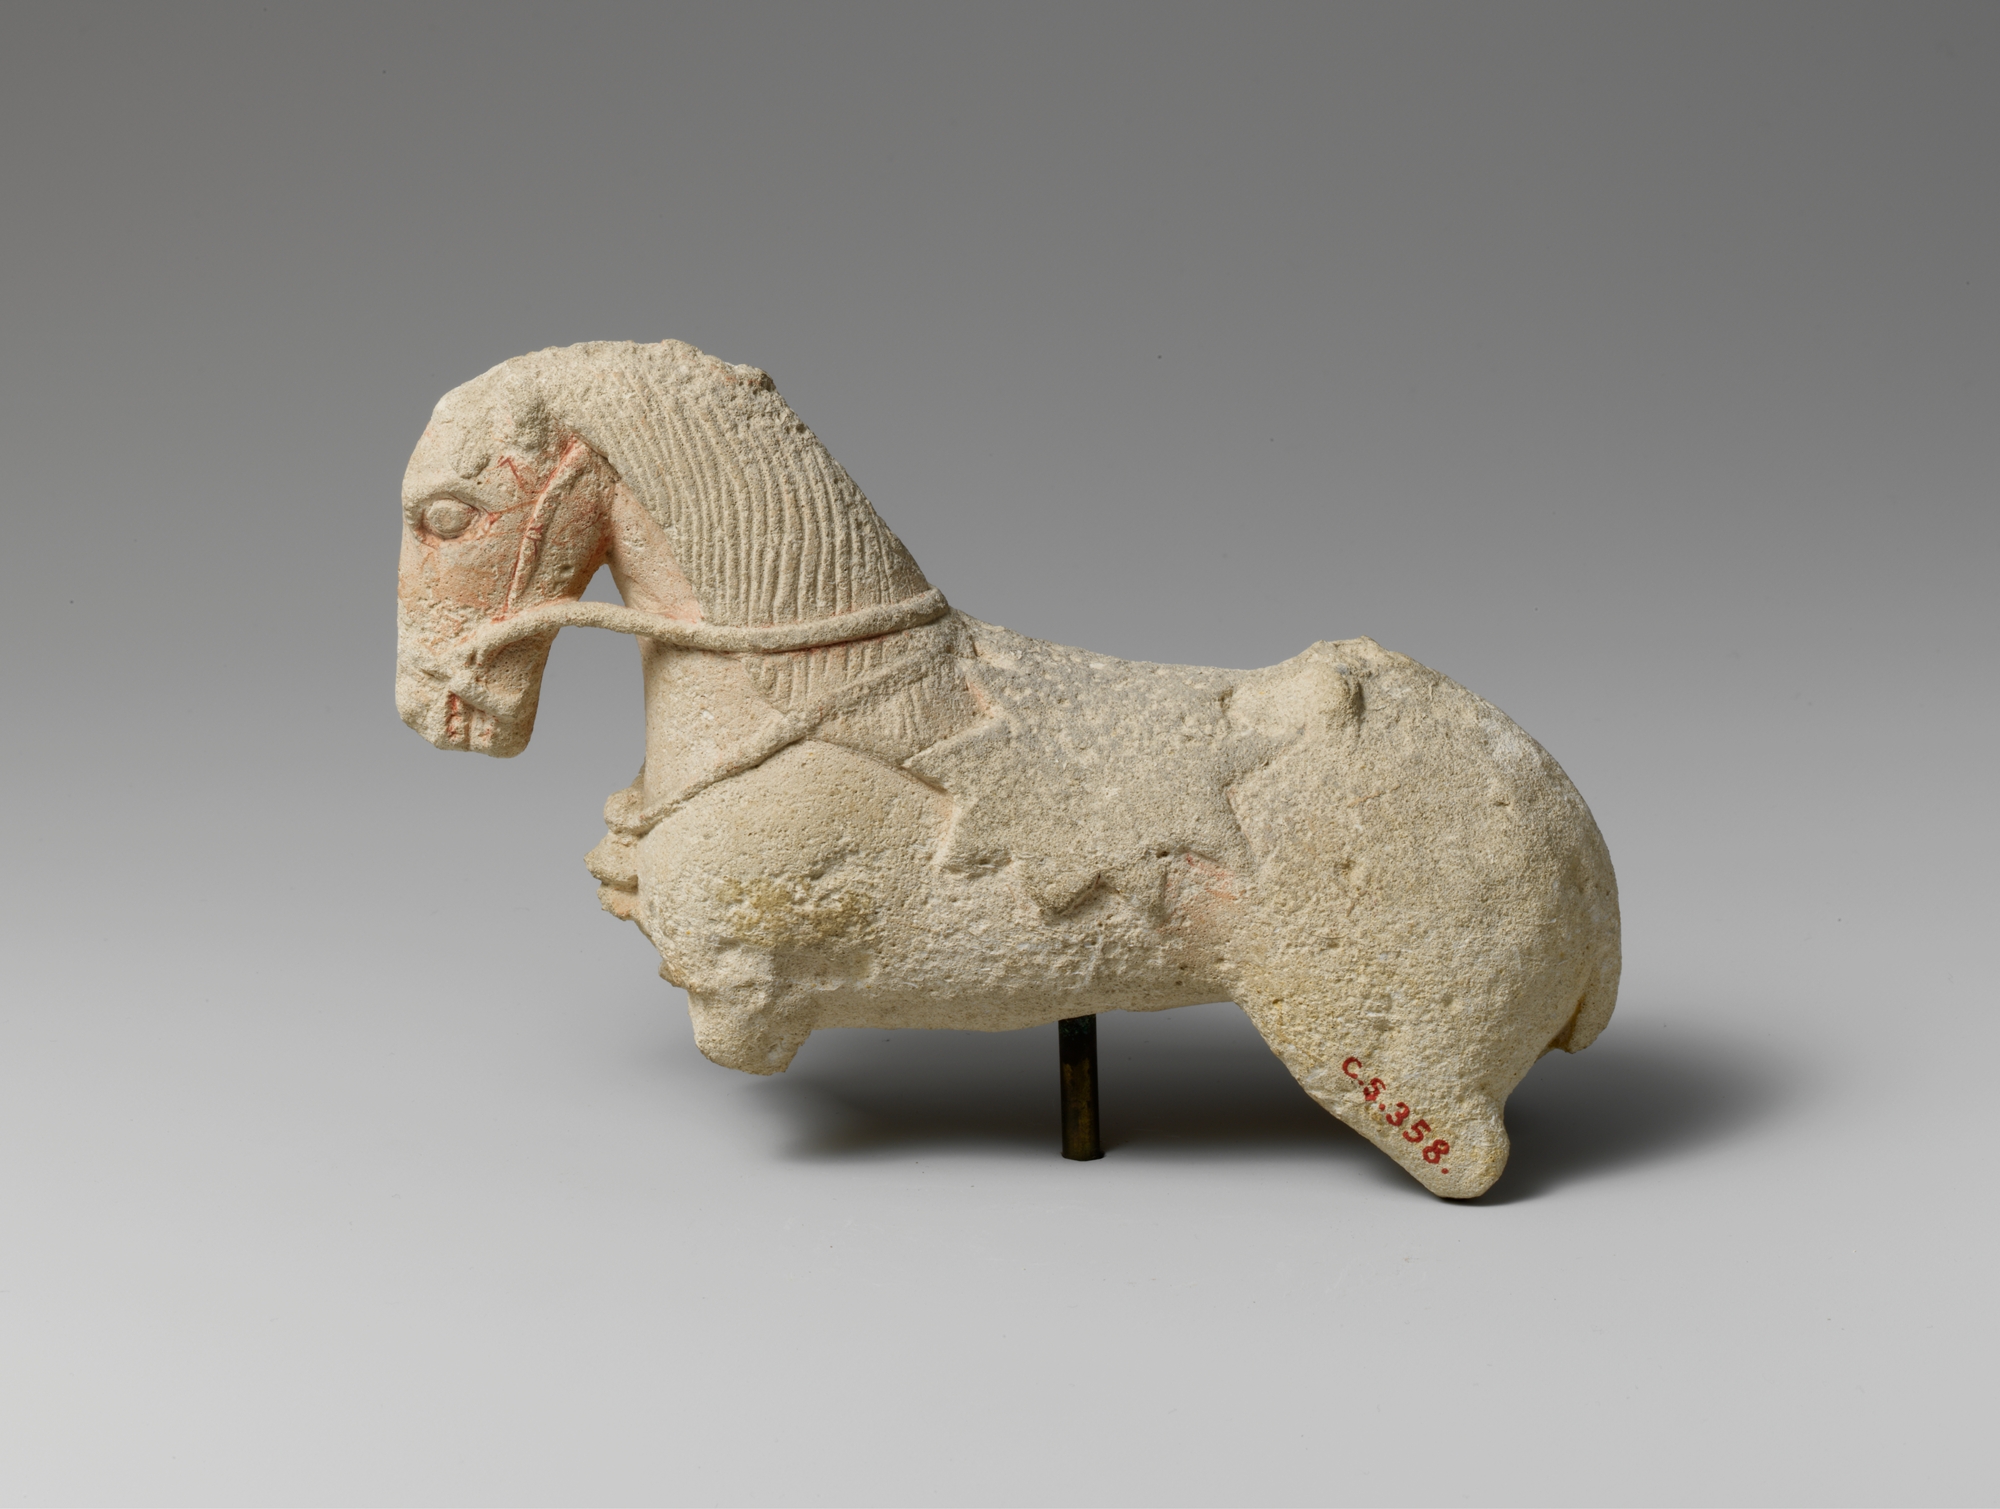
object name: statuette of a horse with saddle and bridle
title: Limestone statuette of a horse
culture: cypriot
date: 500-451 BCE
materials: limestone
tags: horses